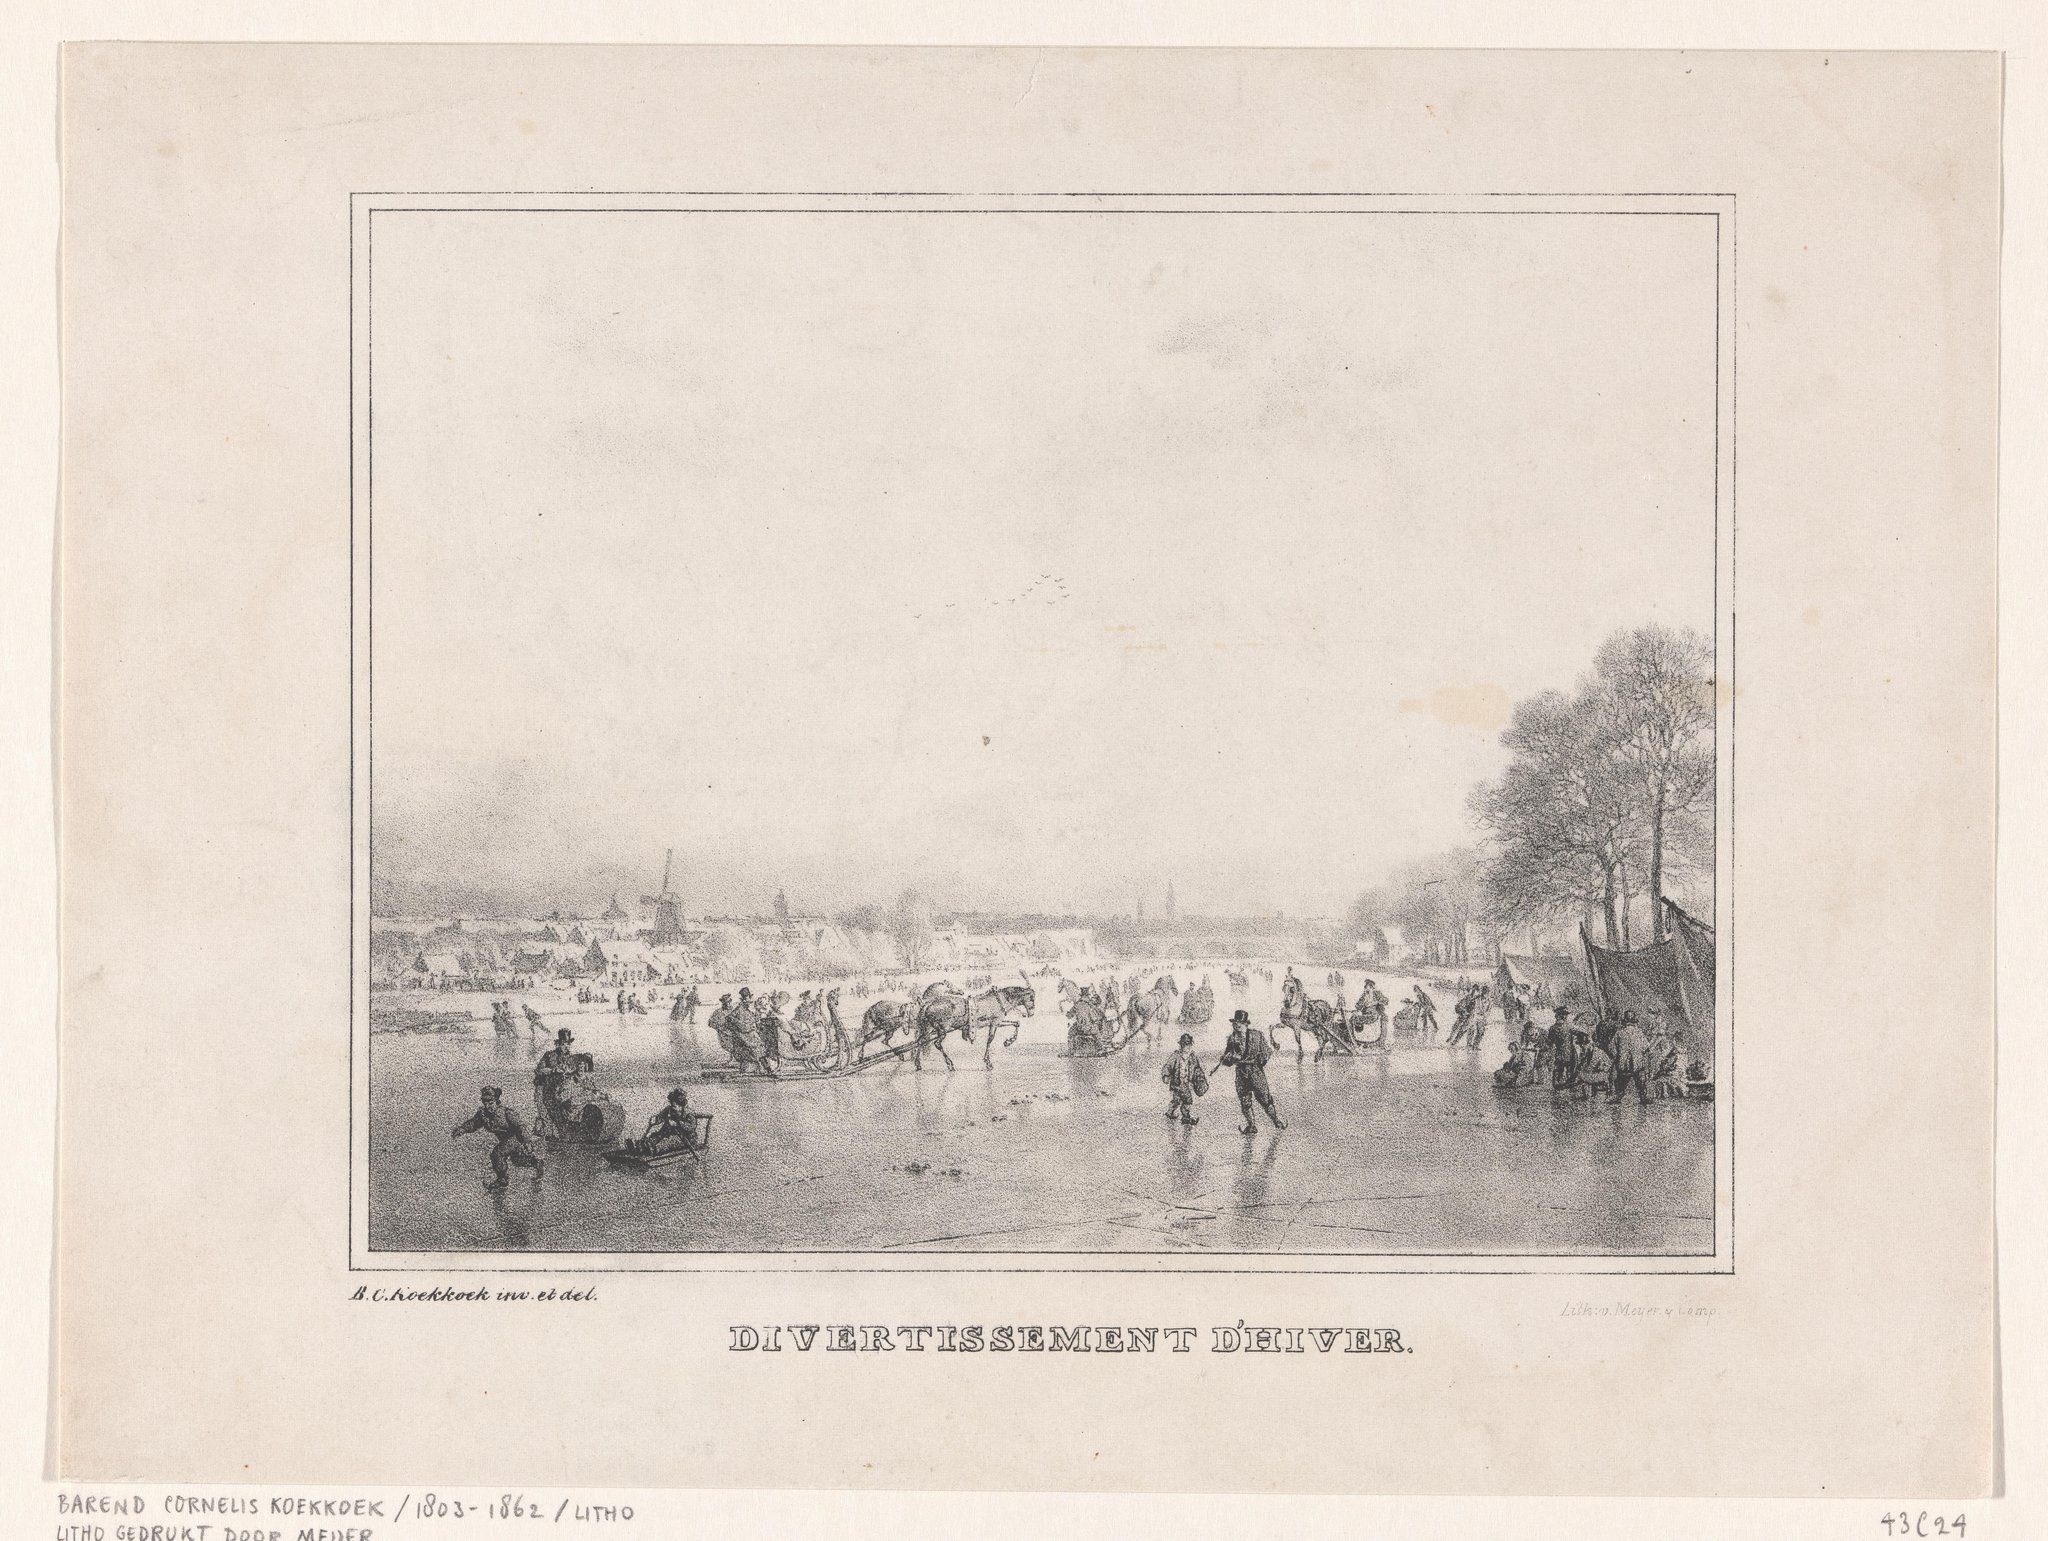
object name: print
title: Boslandschap met figuur onder een boom aan het water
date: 1853-1854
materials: paper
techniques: lithography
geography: paris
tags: trees, forest, wood (+ landscape with figures, staffage), water course (+ landscape with figures, staffage)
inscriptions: collector's mark: Lugt 2228a, check stamp: Lugt 36a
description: Prent gebruikt voor: Les Artistes anciens et modernes, dl. 3, vol. 5, 1853-1854.